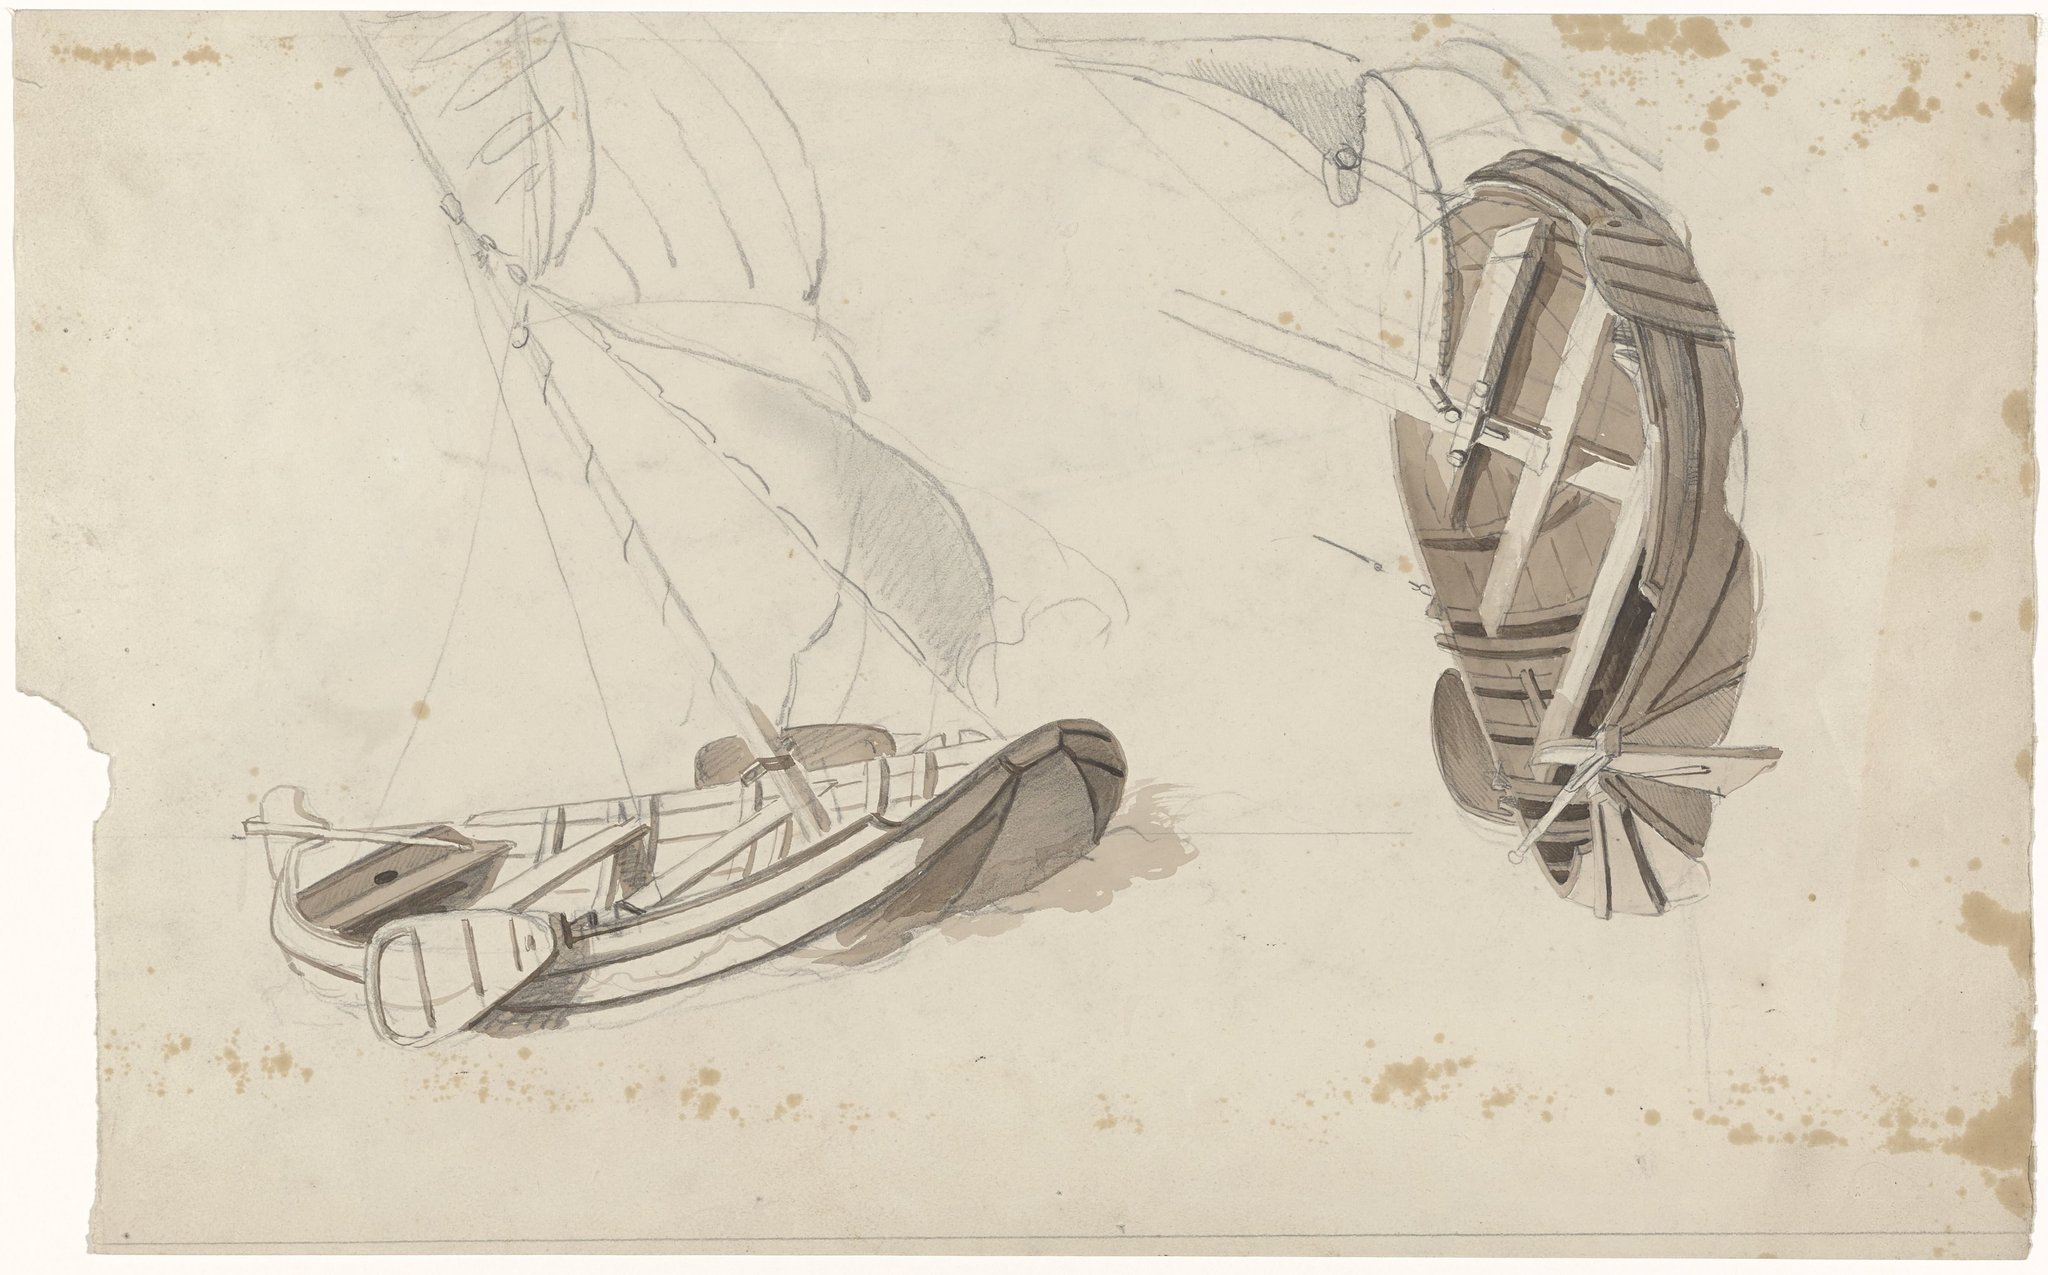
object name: drawing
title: Twee schetsen van een zeilende schuit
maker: willem gruyter jr.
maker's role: draughtsman, print maker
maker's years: 1817-1880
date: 1827-1880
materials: paper, pencil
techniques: brush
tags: sailing-ship, sailing-boat